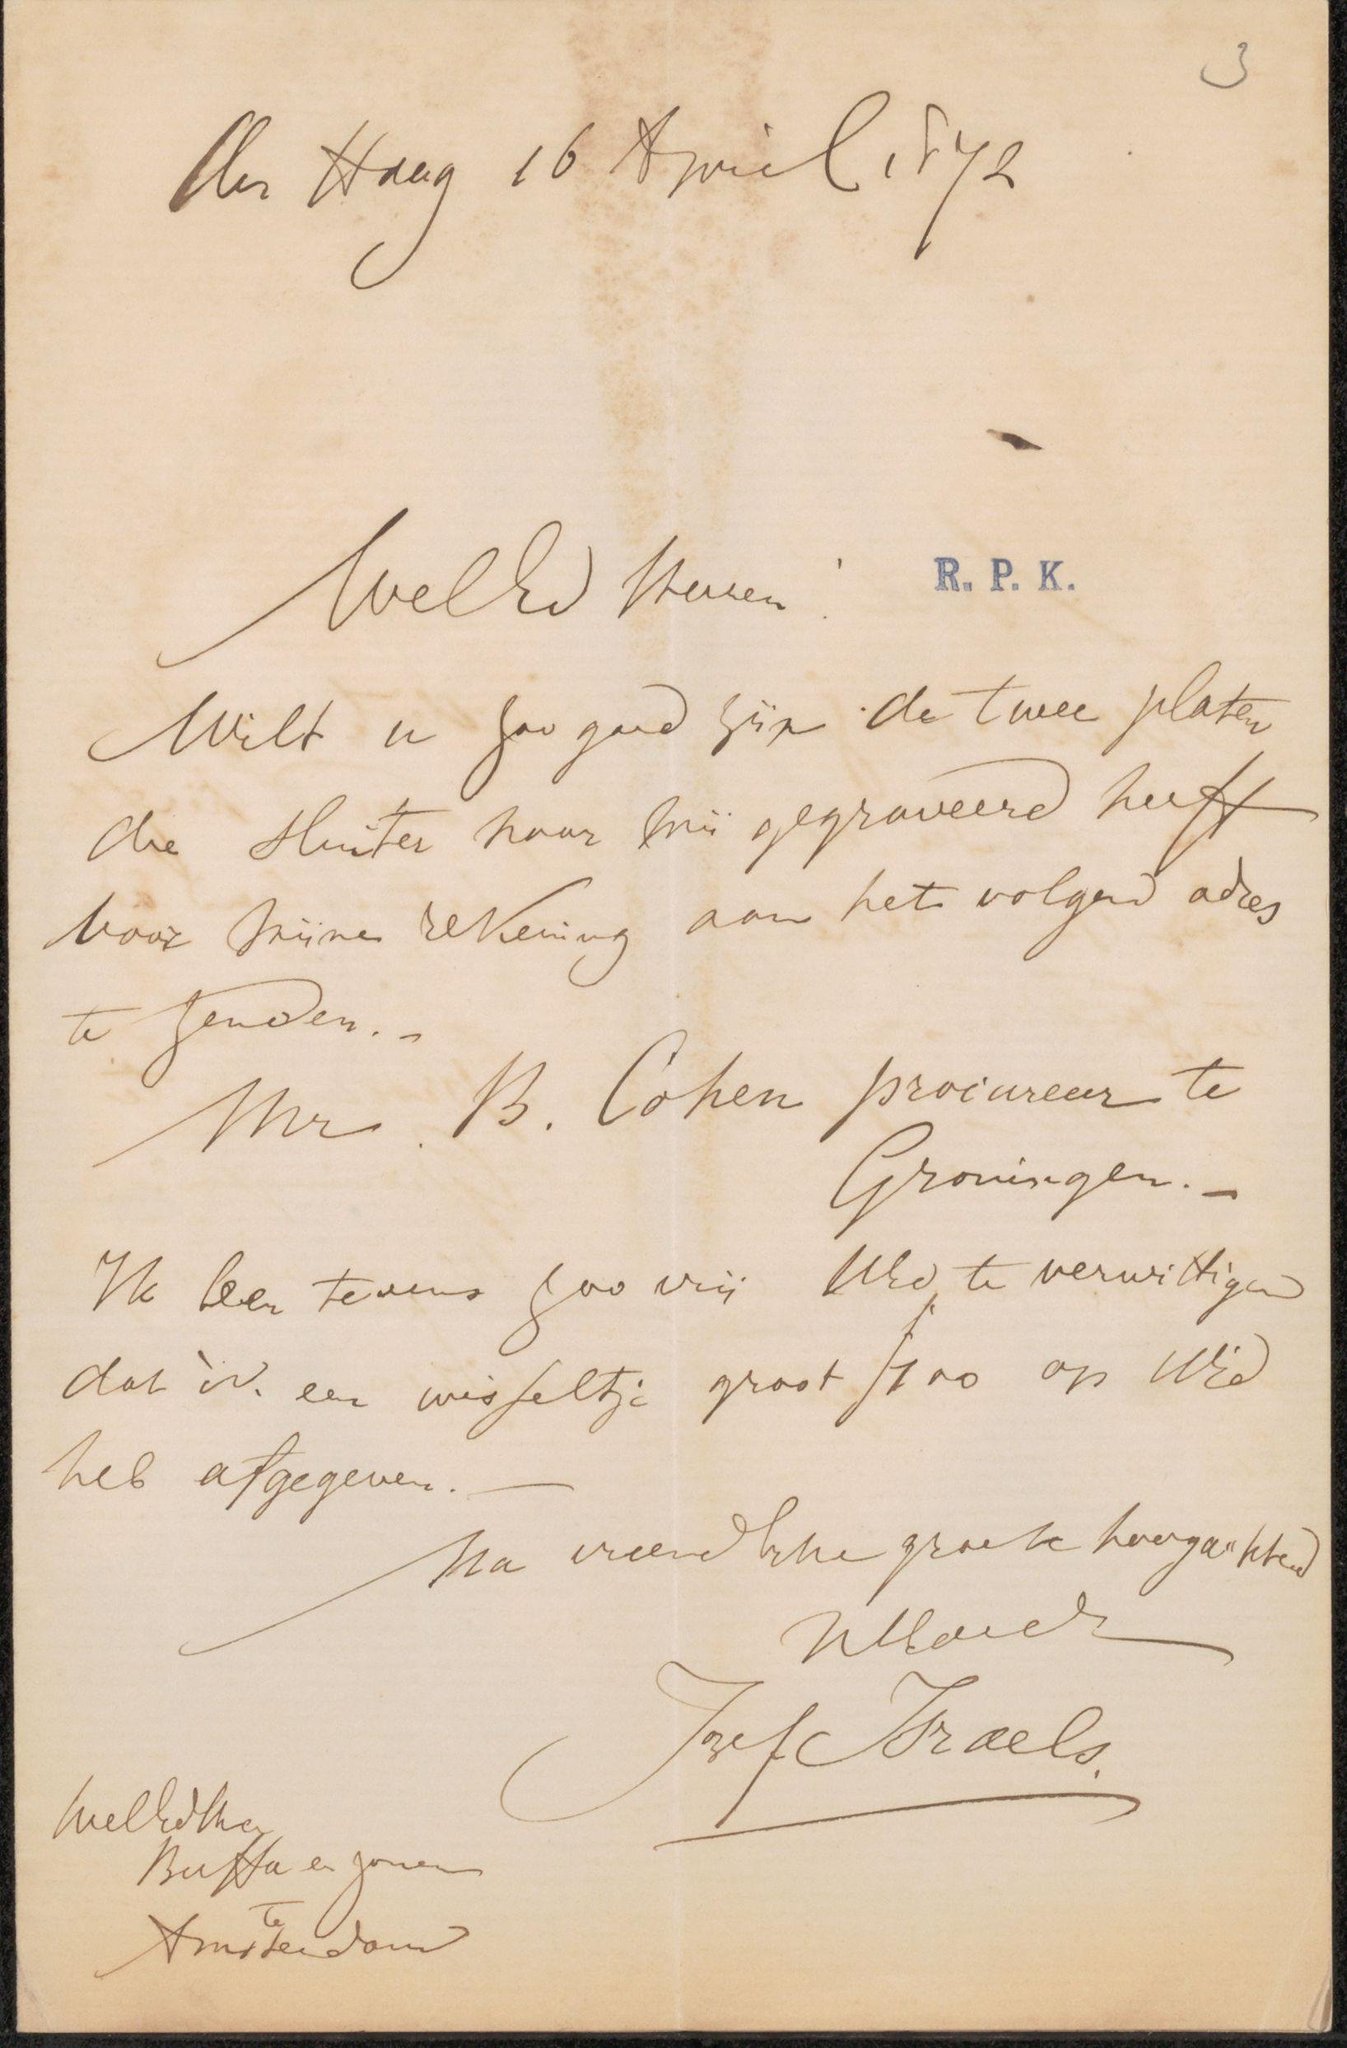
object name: letter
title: Brief aan Frans Buffa en Zonen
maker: jozef israëls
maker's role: draughtsman, painter, print maker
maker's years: 1824-1911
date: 1872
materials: ink, paper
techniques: pen, writing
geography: the hague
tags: publisher, the graphic arts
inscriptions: collector's mark: Lugt 2233